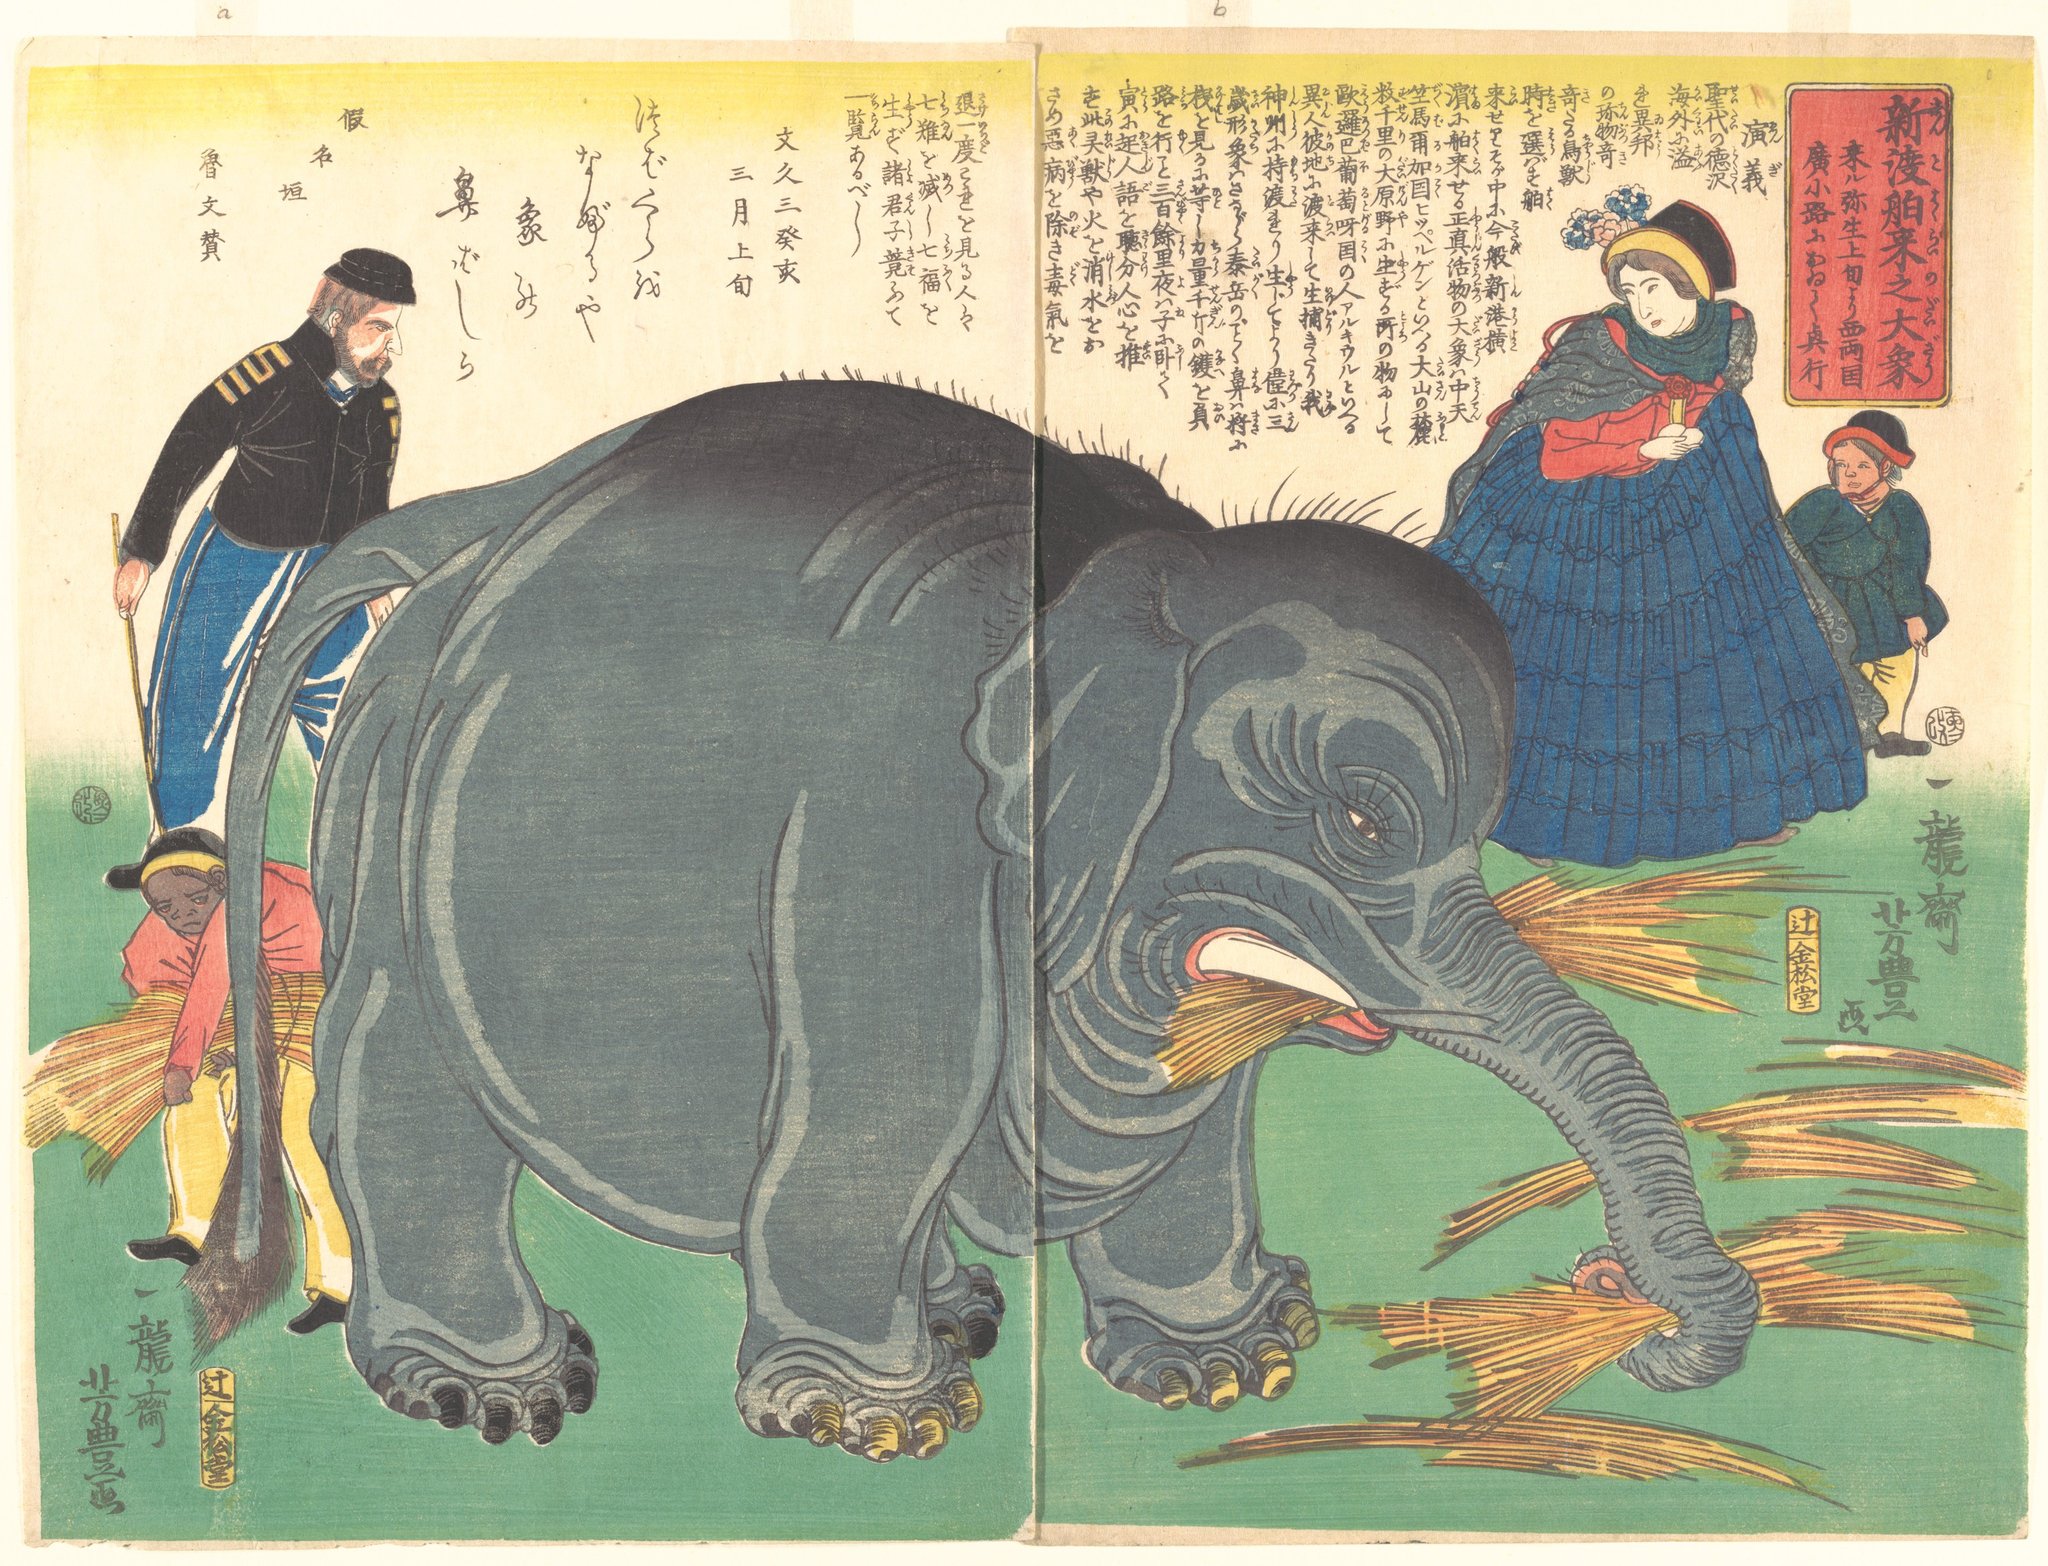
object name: woodblock print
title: Recently Imported Big Elephant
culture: japanese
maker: ichiryūsai yoshitoyo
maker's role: artist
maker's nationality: japanese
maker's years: 1830-1866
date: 1863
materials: ink, paper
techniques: woodblock print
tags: men,women,elephants